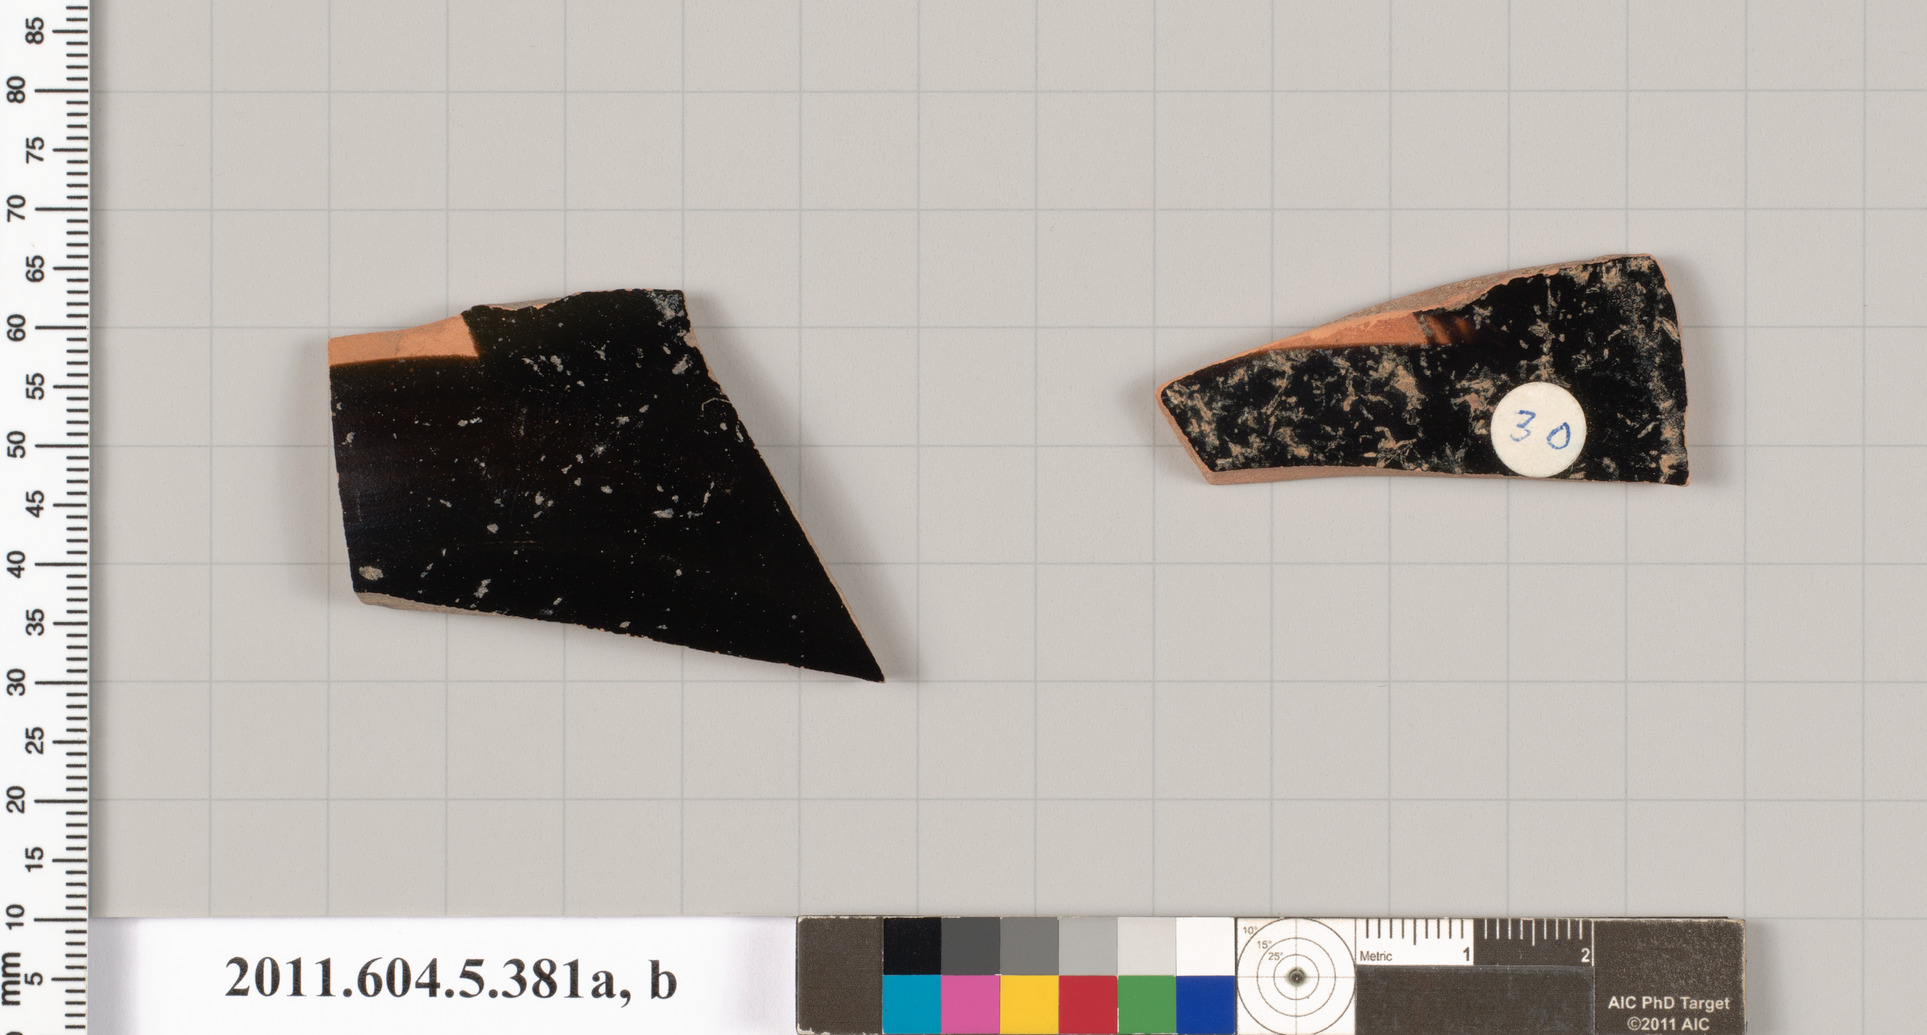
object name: kylix fragment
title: Terracotta fragments of kylikes (drinking cups)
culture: greek, attic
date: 600-401 BCE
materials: terracotta